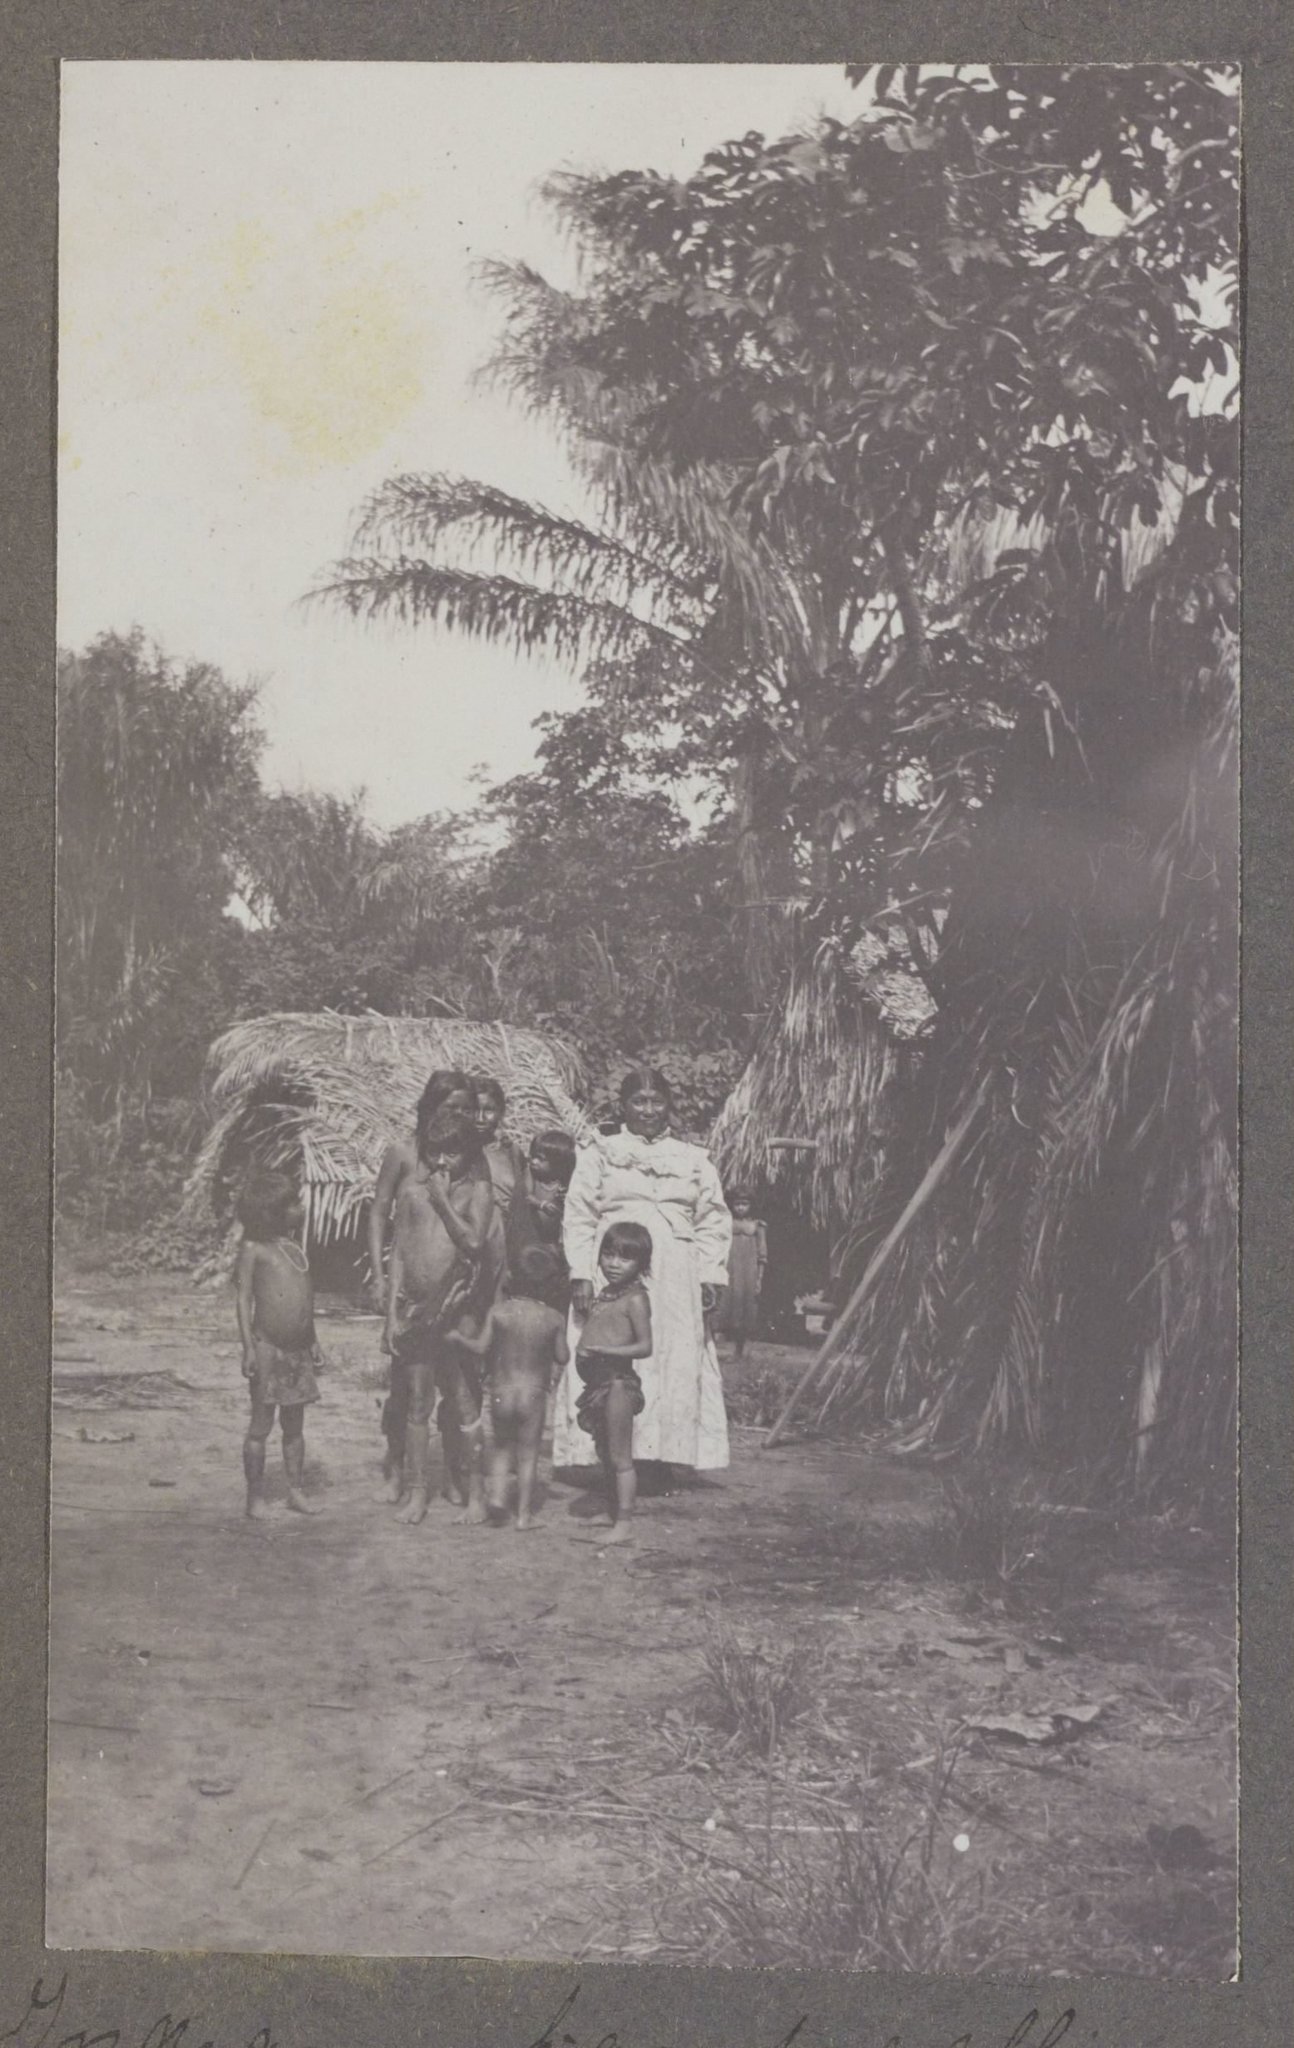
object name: photograph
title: Nederzetting bij Albina, Suriname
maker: Anonymous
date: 1912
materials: photographic support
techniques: photography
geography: suriname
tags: indigenous peoples of south america, village (+ city(-scape) with figures, staffage), suriname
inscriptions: inscription: ‘Indianen kamp Albina 19/12-12’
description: Een familie van Surinaamse indianen (mogelijk Arowakken) poseert voor een hut in het dorp Albina. Tijdens een bezoek aan het dorp door de familie Gonggrijp op 18-19 december 1912. Onderdeel van een groep van elf albumbladen met familiefoto's van de familie Gonggrijp in Suriname, ca. 1912.